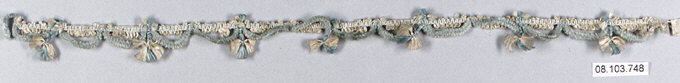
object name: gimp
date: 1701-1800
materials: silk